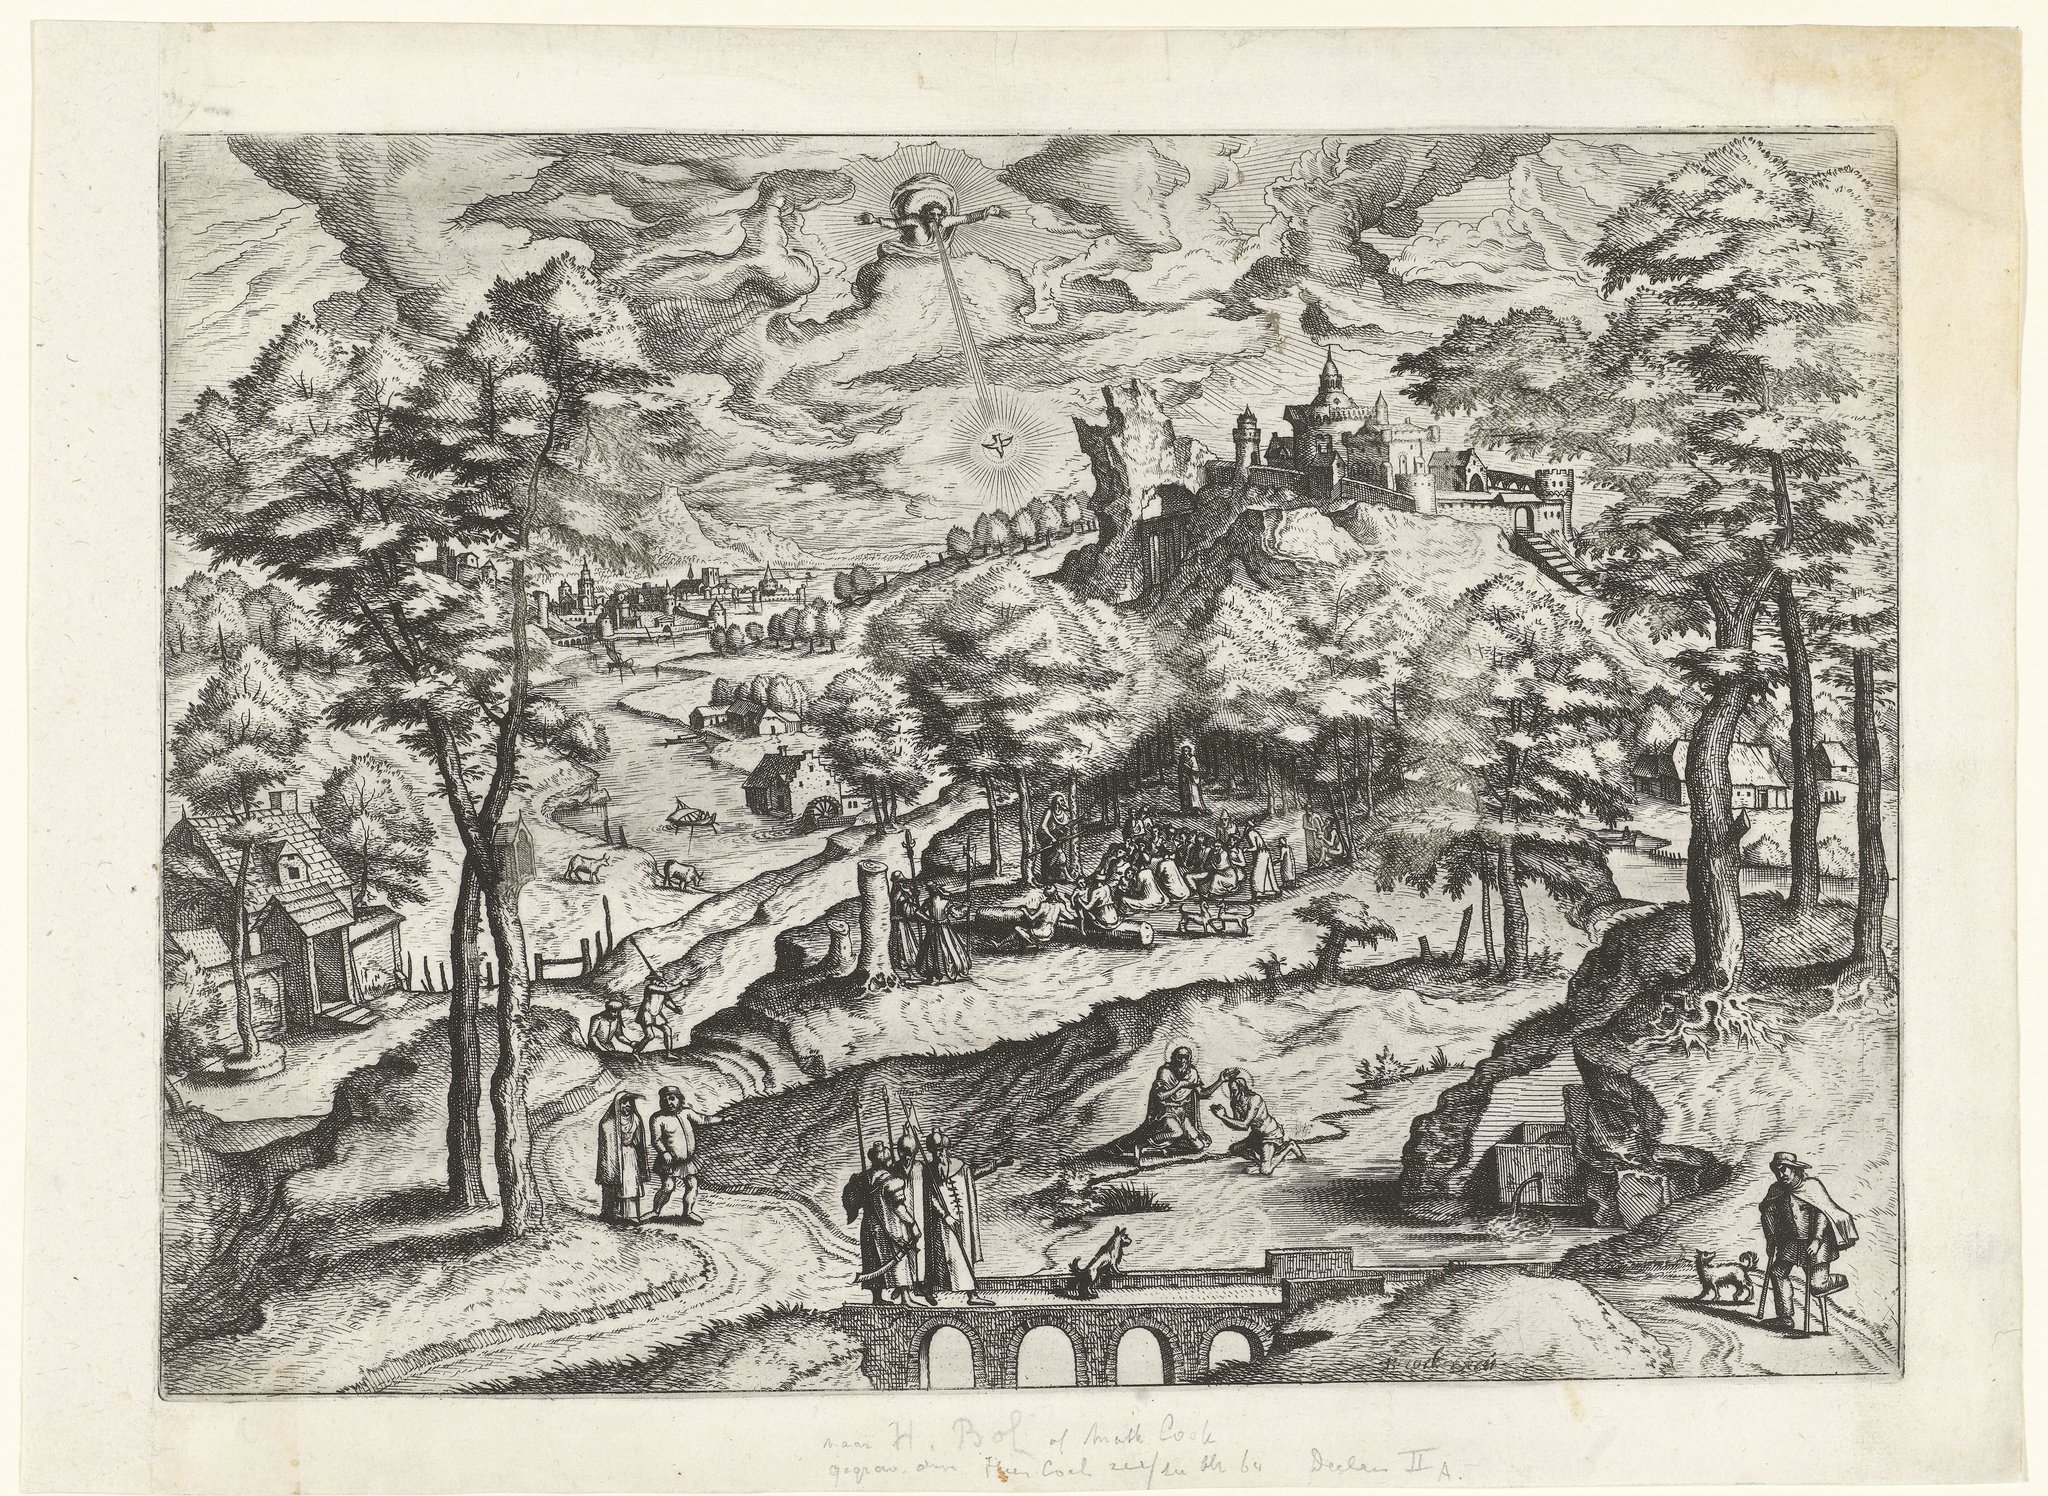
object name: print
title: Landschap met doop van Christus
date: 1560-1564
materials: paper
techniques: engraving, etching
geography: antwerp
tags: baptism of christ in the river jordan: john the baptist pouring out water on christ's head: the holy ghost descends, landscapes (+ landscape with figures, staffage), john the baptist disputing (+ holy ghost (as dove))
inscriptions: collector's mark: Lugt 2228, collector's mark: Lugt 2228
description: Landschap met op de voorgrond de doop van Christus in de Jordaan. Op de achtergrond predikt Johannes de Doper op een open plek in een bos. Boven in de lucht God de Vader die de Heilige Geest (een duif) naar de aarde stuurt. De prent is deel van een serie van landschappen met christelijke verhalen als thema.